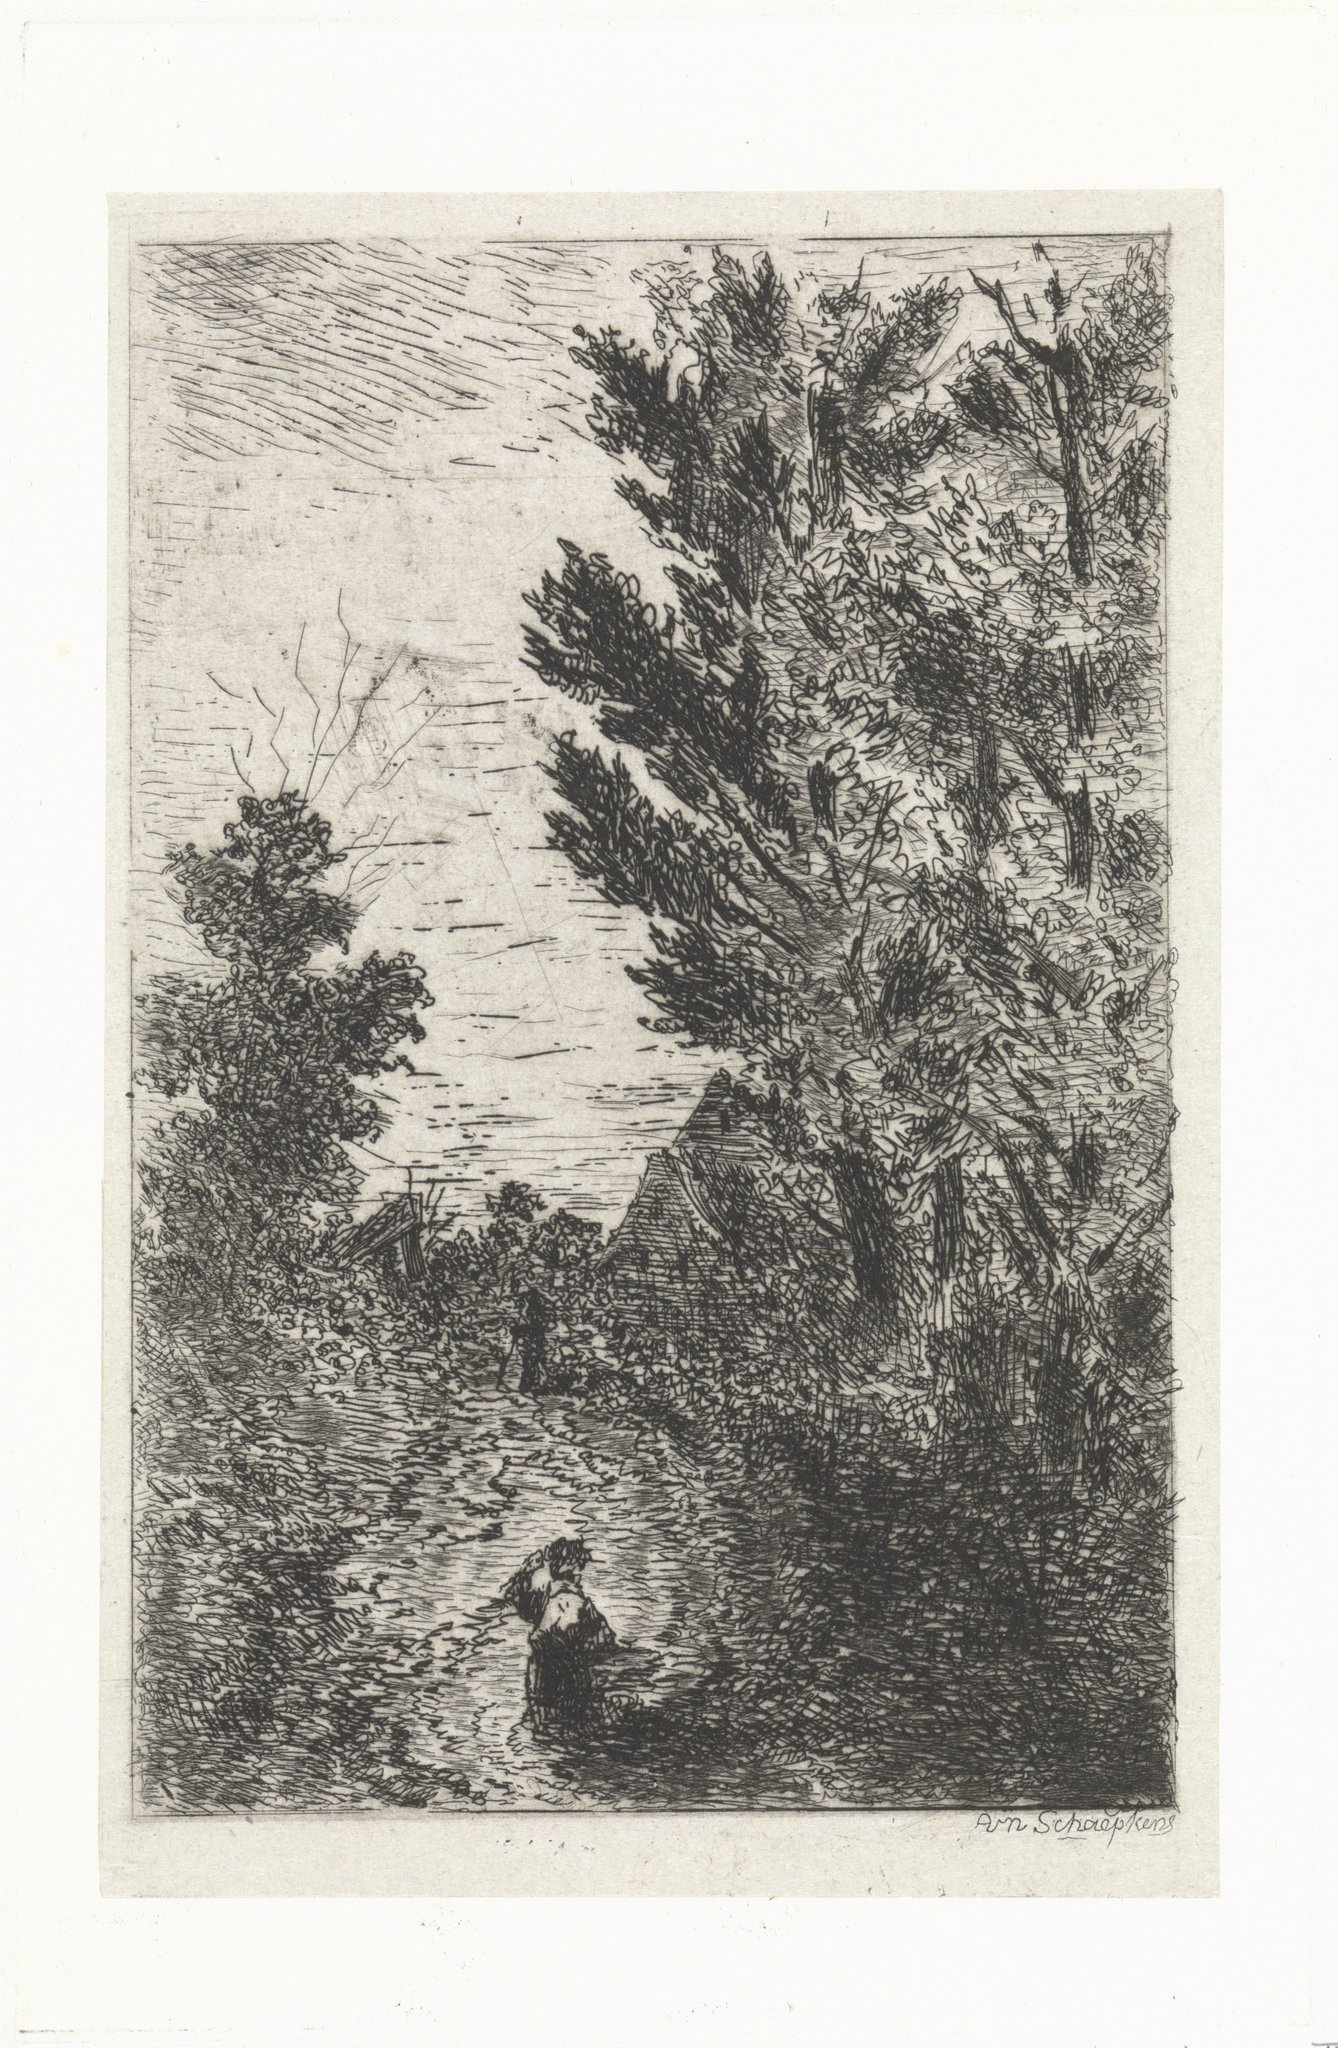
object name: print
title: Landweg met wandelaars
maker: arnoud schaepkens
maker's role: print maker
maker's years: 1816-1904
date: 1831-1888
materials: paper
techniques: drypoint, etching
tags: landscapes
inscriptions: collector's mark: Lugt 2228